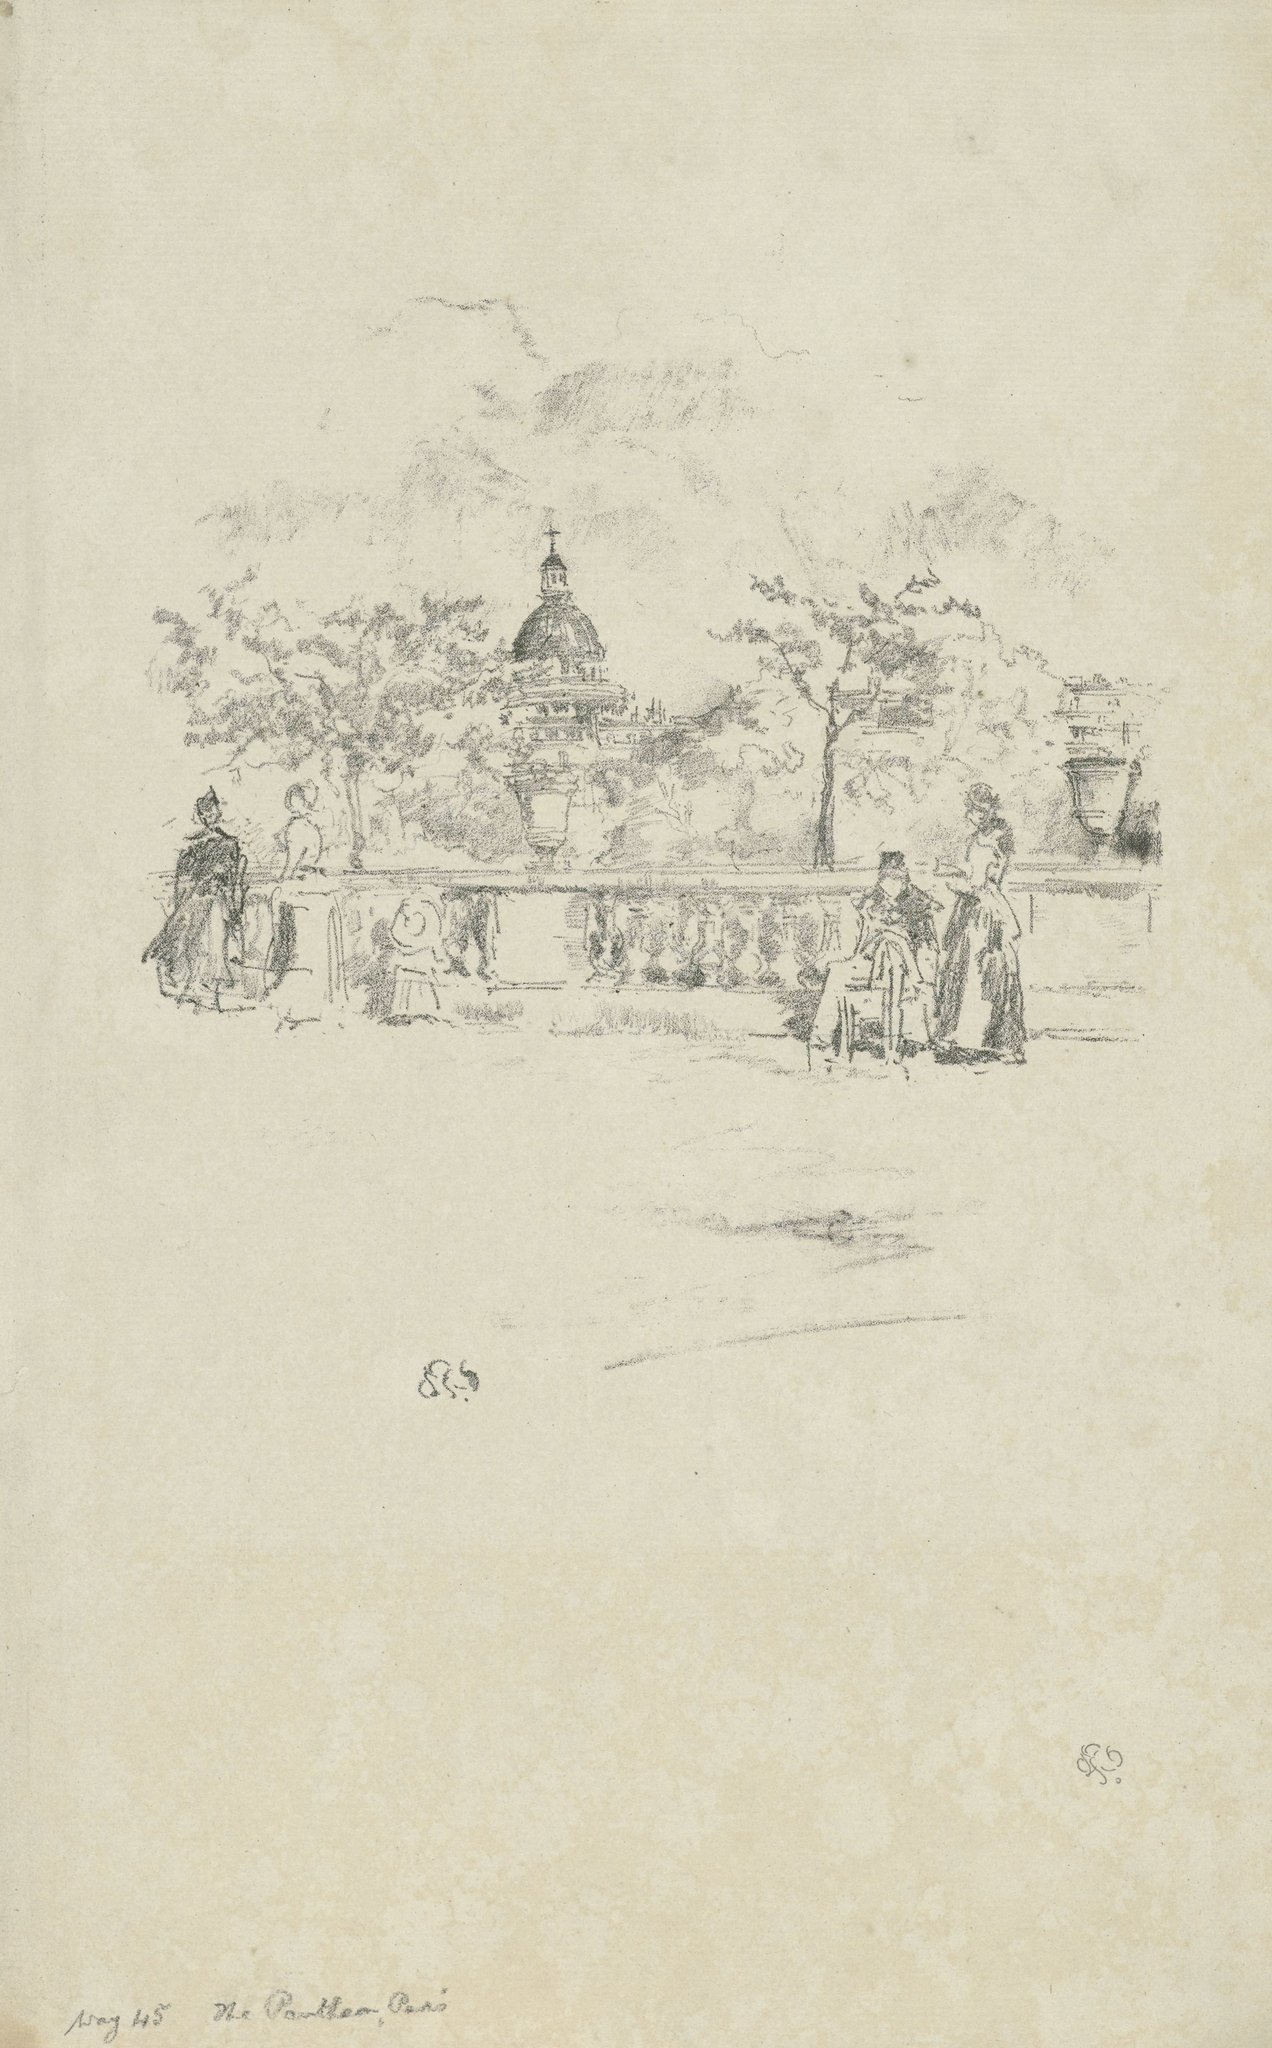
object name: print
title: The Pantheon, from the terrace of the Luxembourg Gardens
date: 1893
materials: paper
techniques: lithograph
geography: london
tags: public gardens, park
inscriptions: collector's mark: 2228, collector's mark: Lugt Lygt 406, signature: ‘JW’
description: Balustrade van een terras in de Jardin du Luxembourg. In de verte de koepel van het Panthéon.